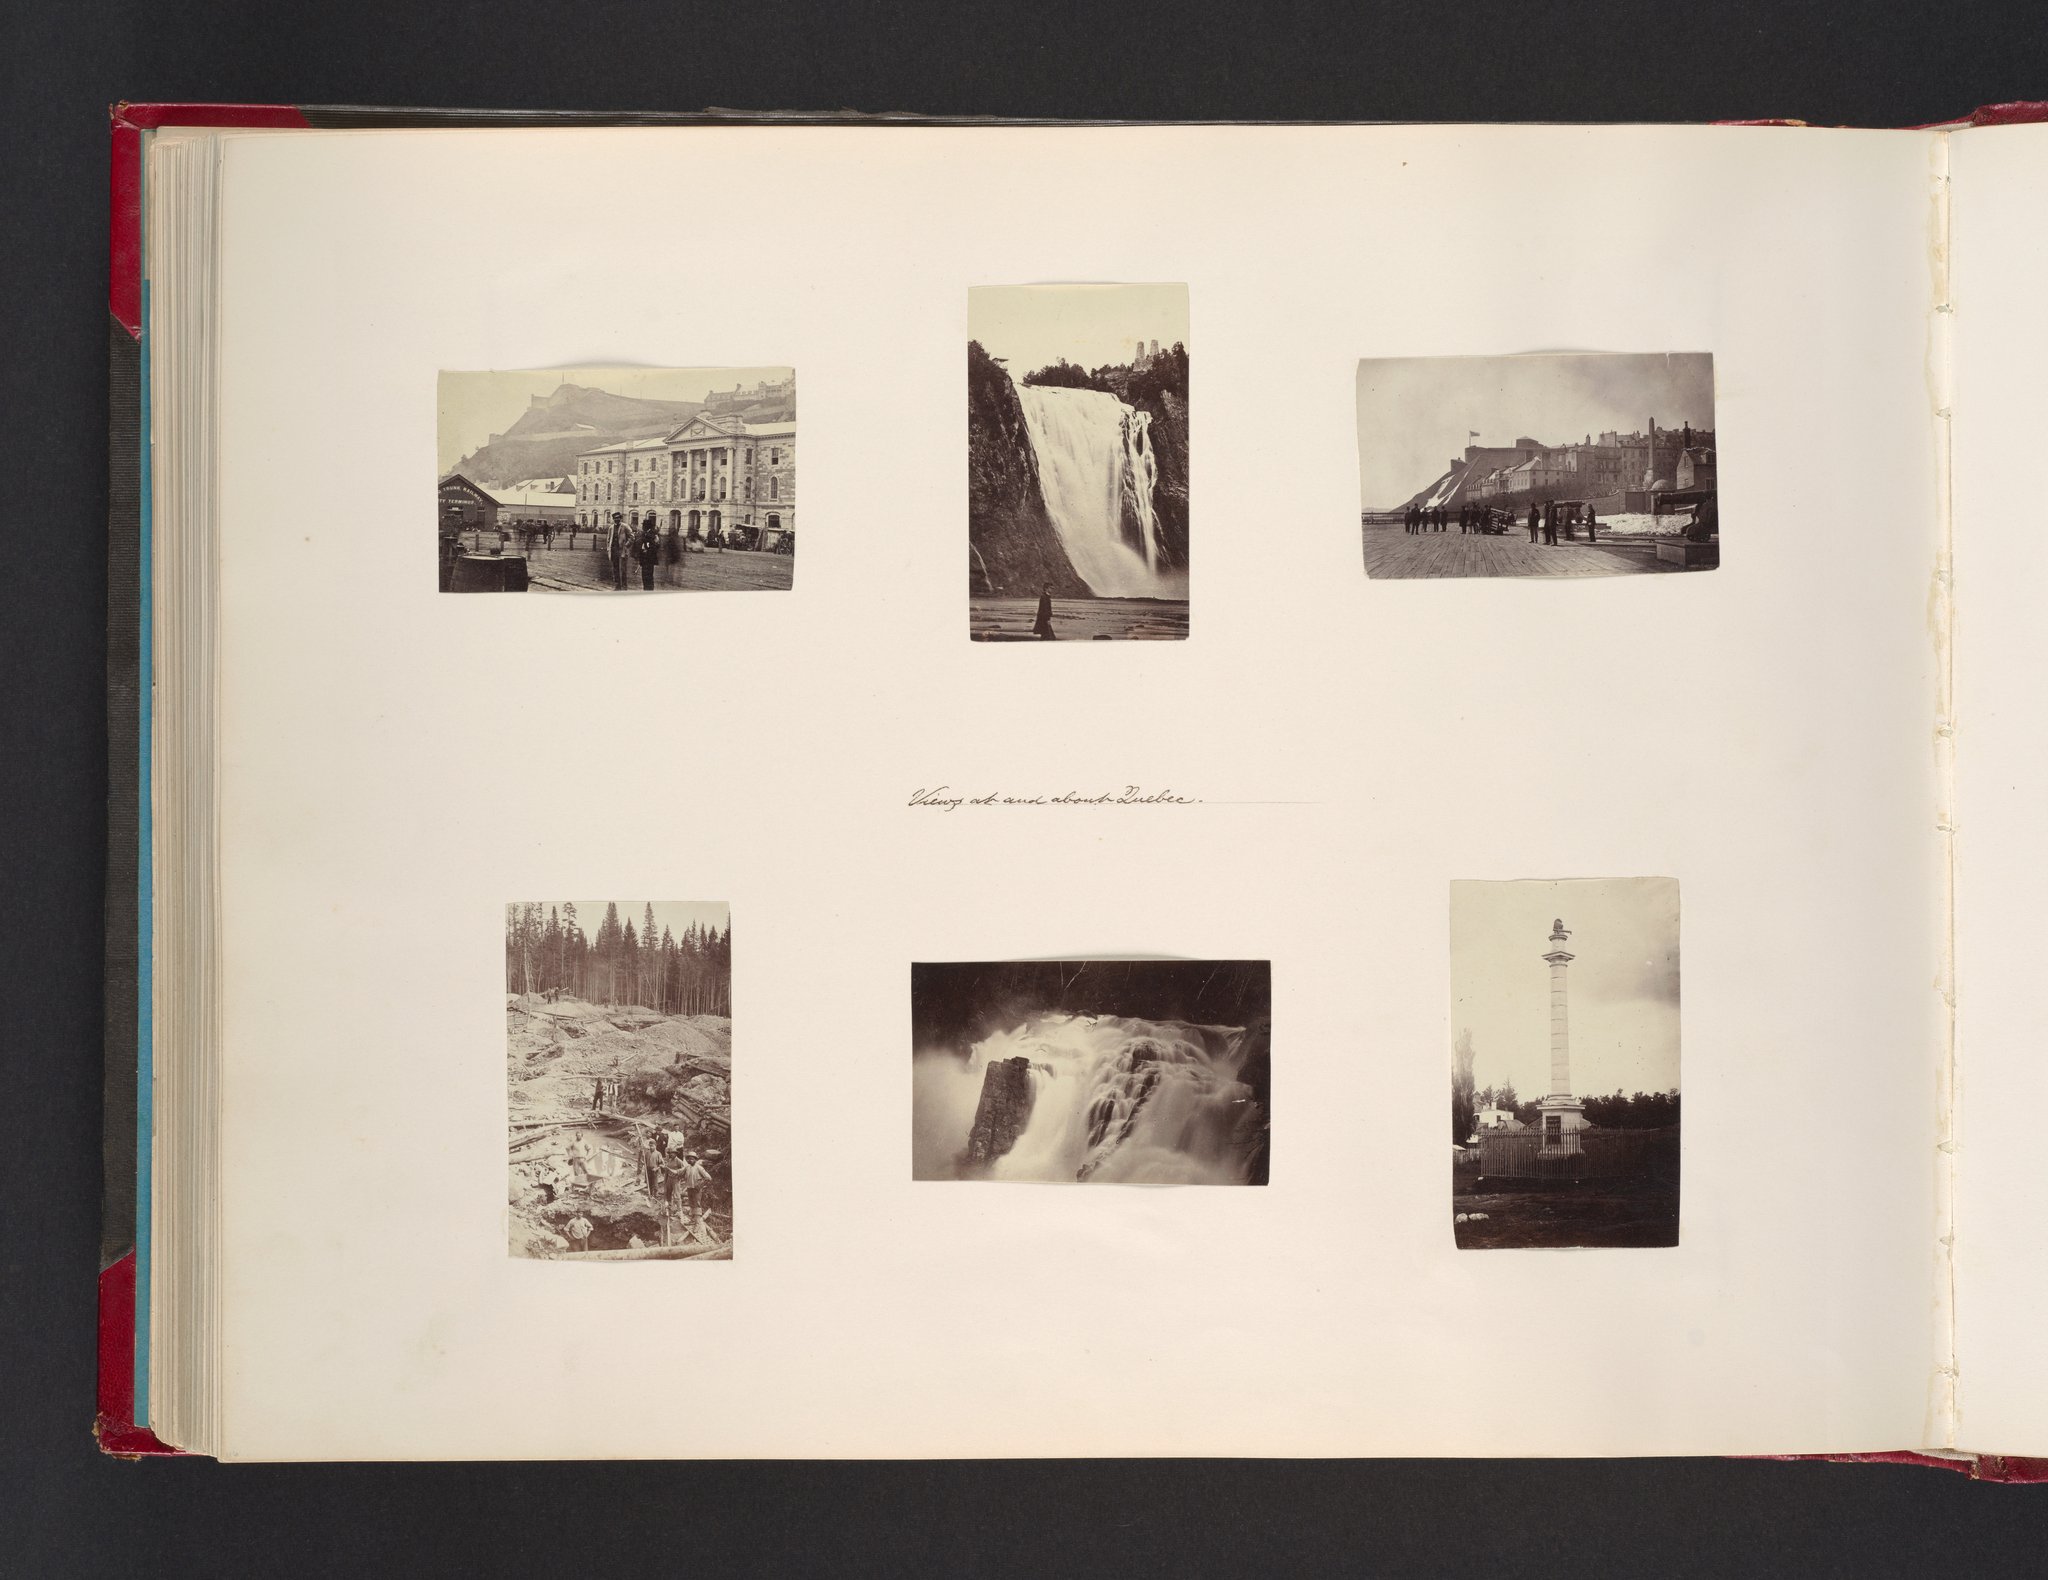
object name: photograph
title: Views At and About Quebec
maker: john thomson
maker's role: artist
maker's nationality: british, scottish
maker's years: 1837-1921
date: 1865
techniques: albumen silver print, glass negative